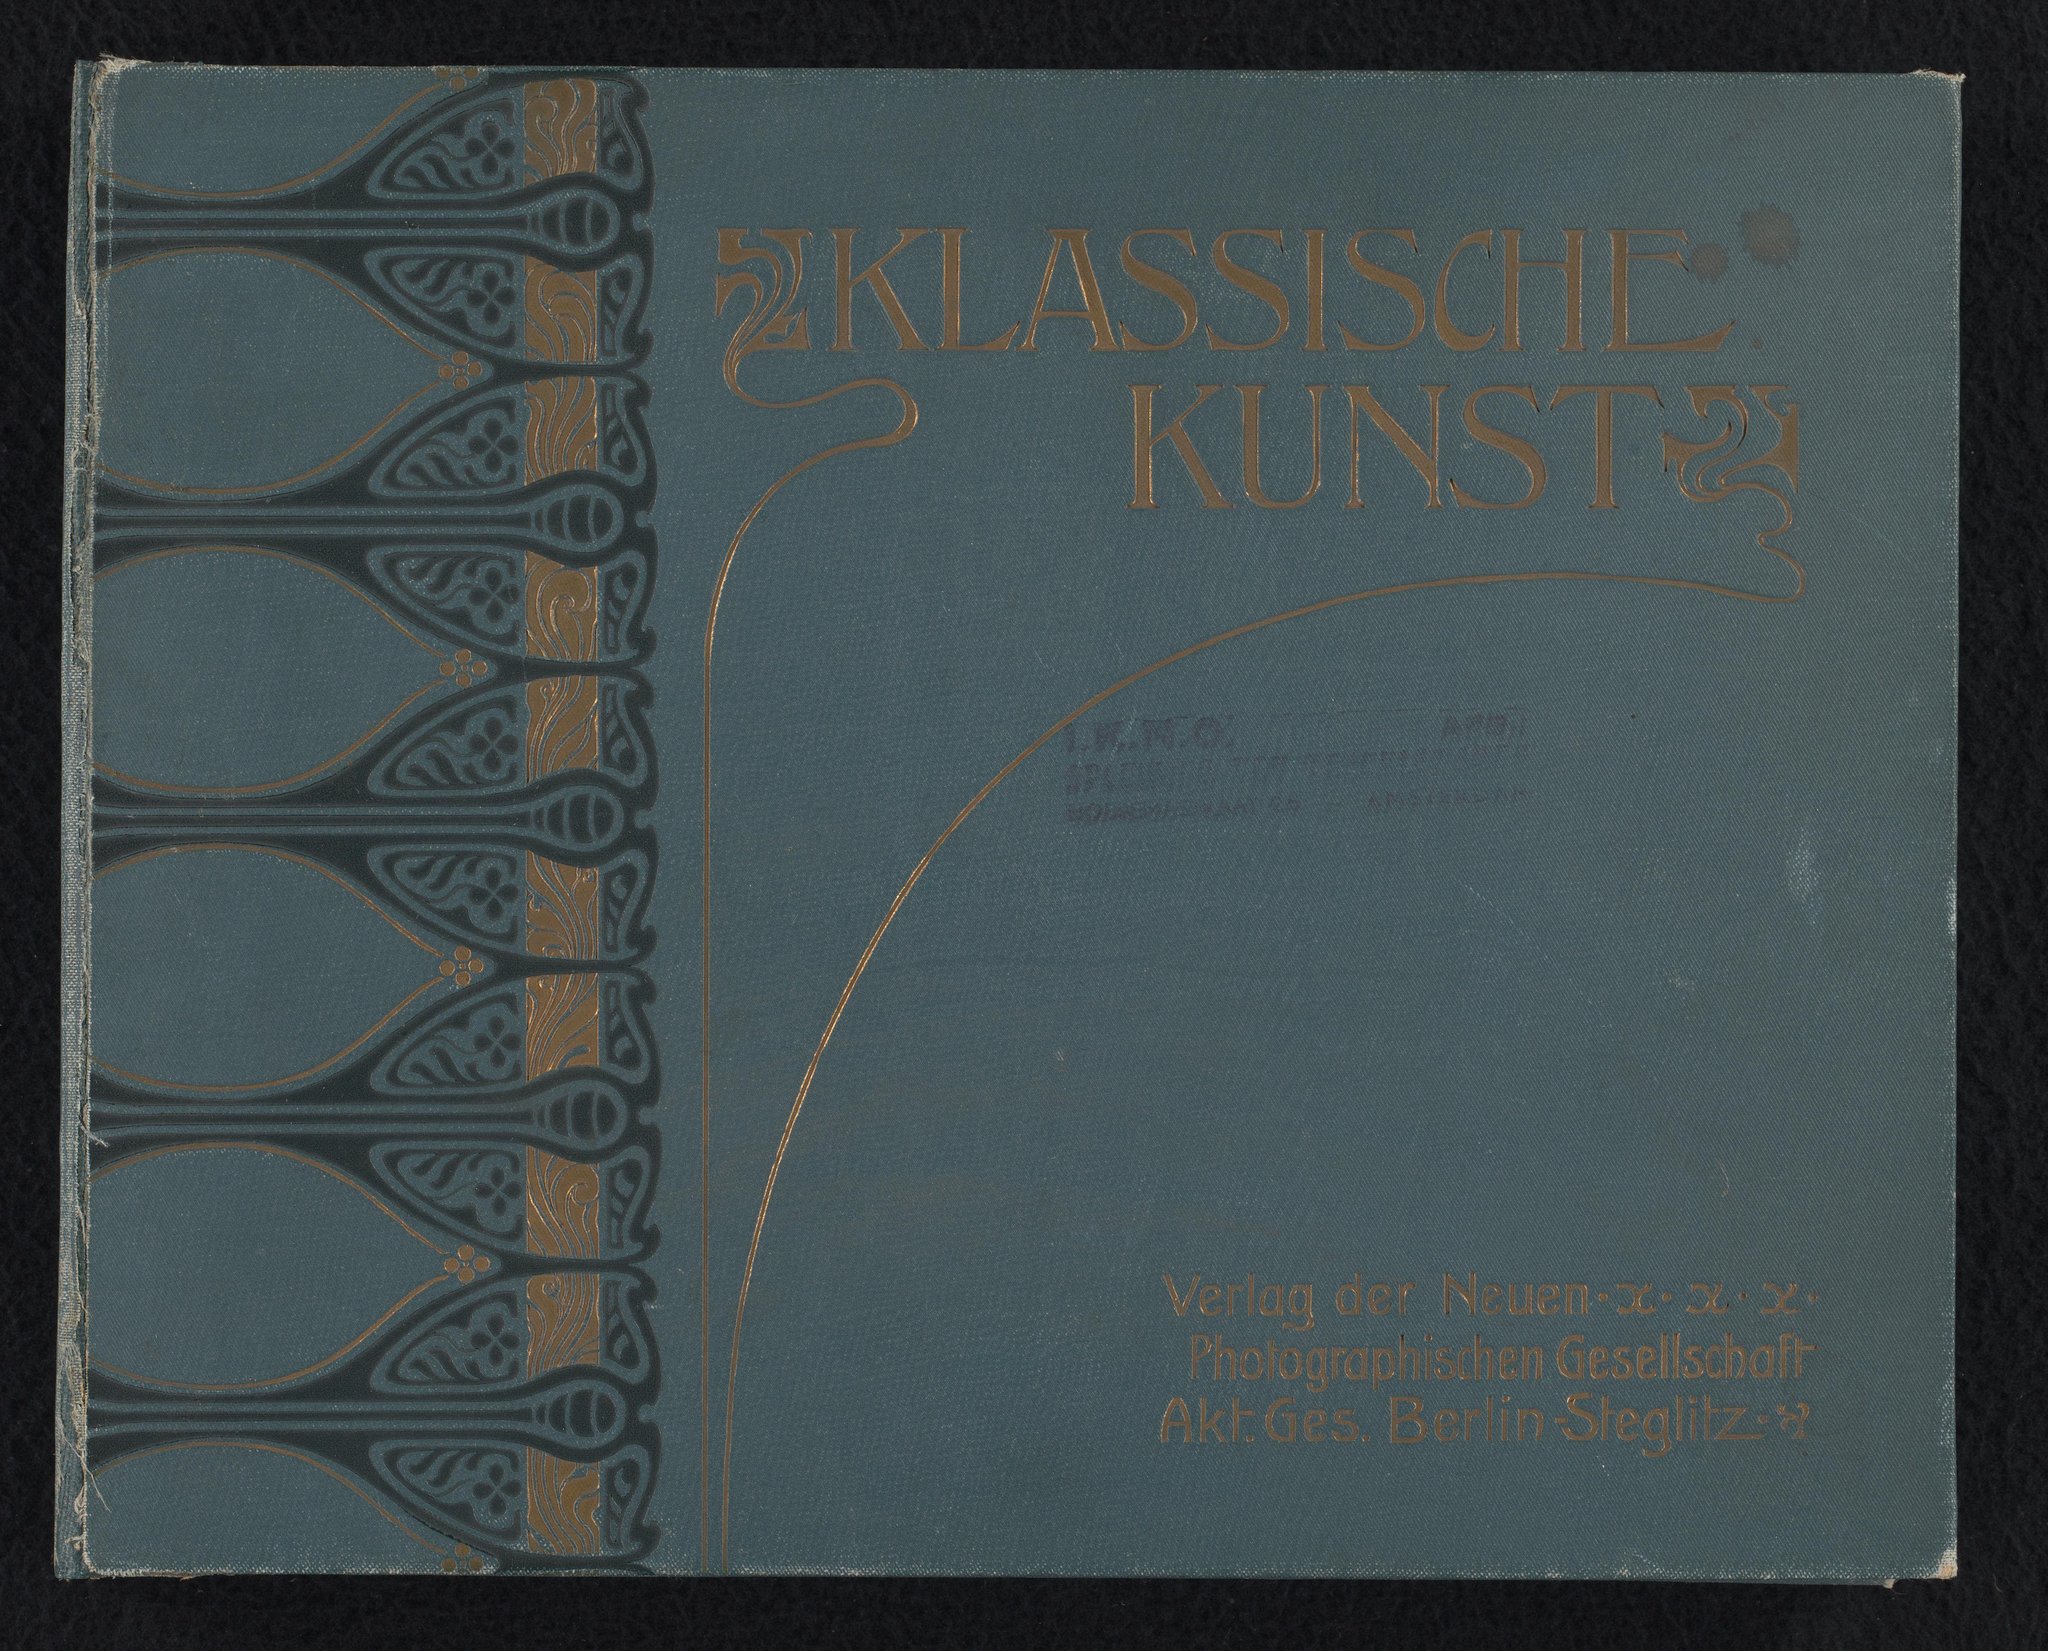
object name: wrapper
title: Klassische Kunst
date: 1901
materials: paper, cardboard, linen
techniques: gelatin silver print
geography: berlin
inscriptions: stamp: ‘I.K.N.O. AFD./ OPLEIDING TOT TEKENLERAAR/ HOBBEMASTRAAT 26 AMSTERDAM’